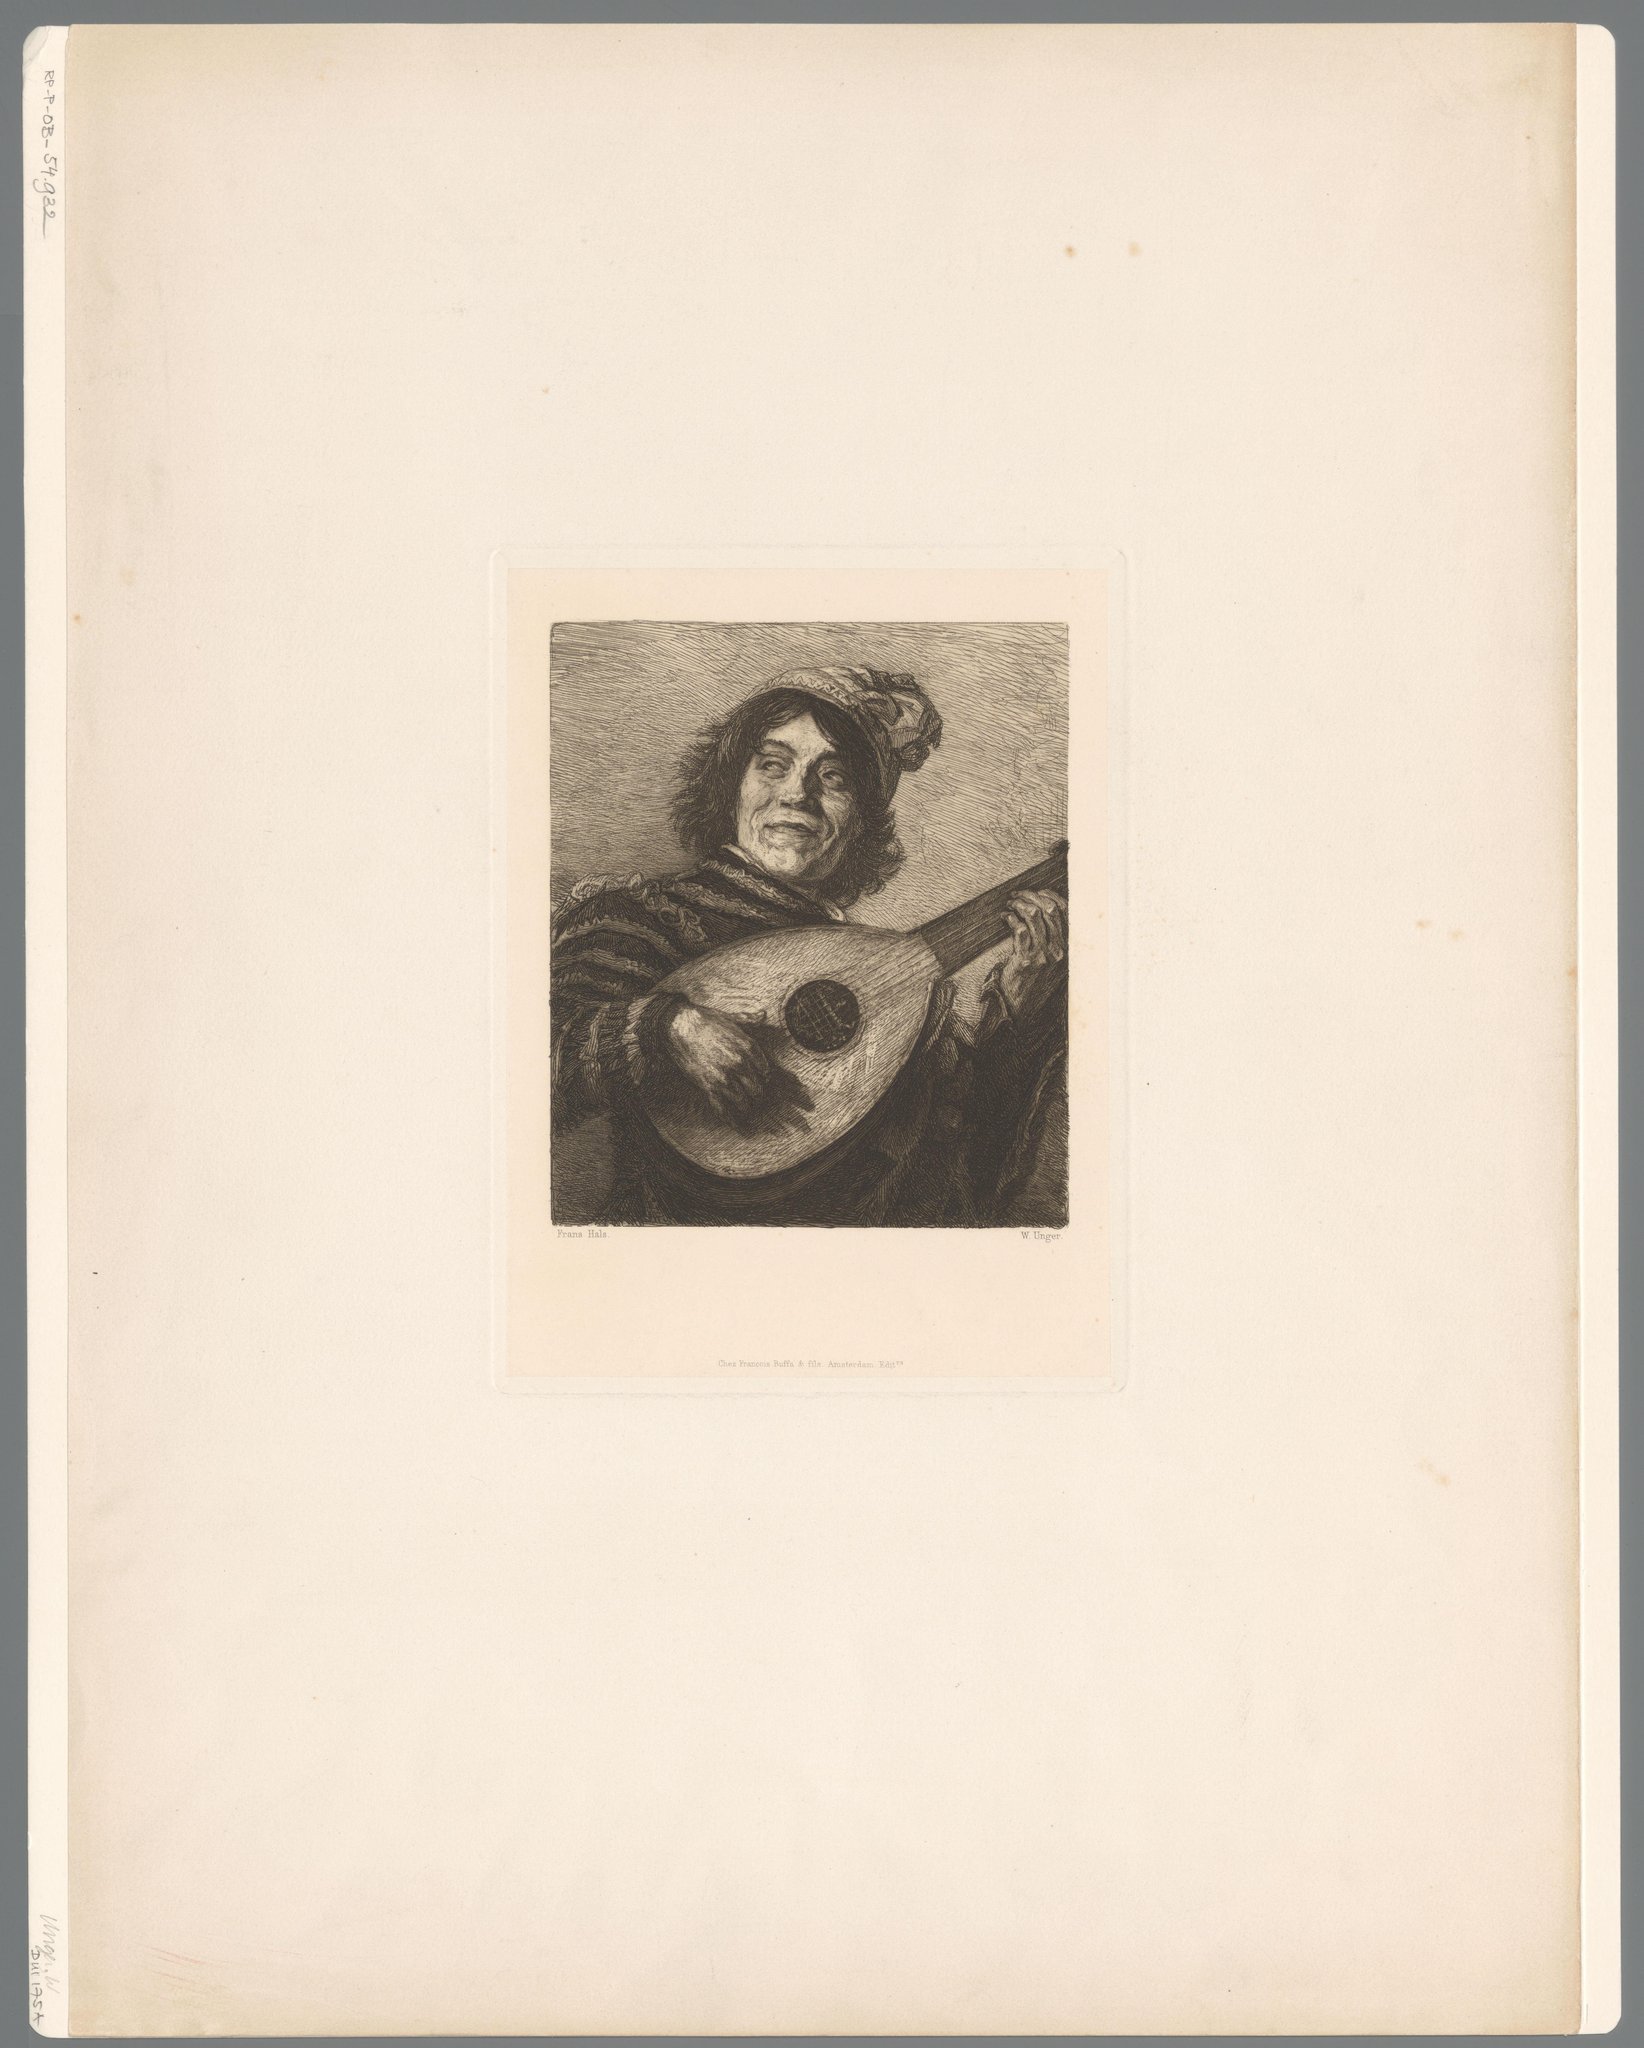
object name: print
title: Jongeman met een luit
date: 1847-1932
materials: paper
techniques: etching, intaglio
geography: amsterdam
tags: youth, adolescent, head-gear: hat, lute, and special forms of lute, e.g.: theorbo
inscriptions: collector's mark: Lugt 2228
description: Prent naar het schilderij door Frans Hals in het Musée du Louvre te Parijs.